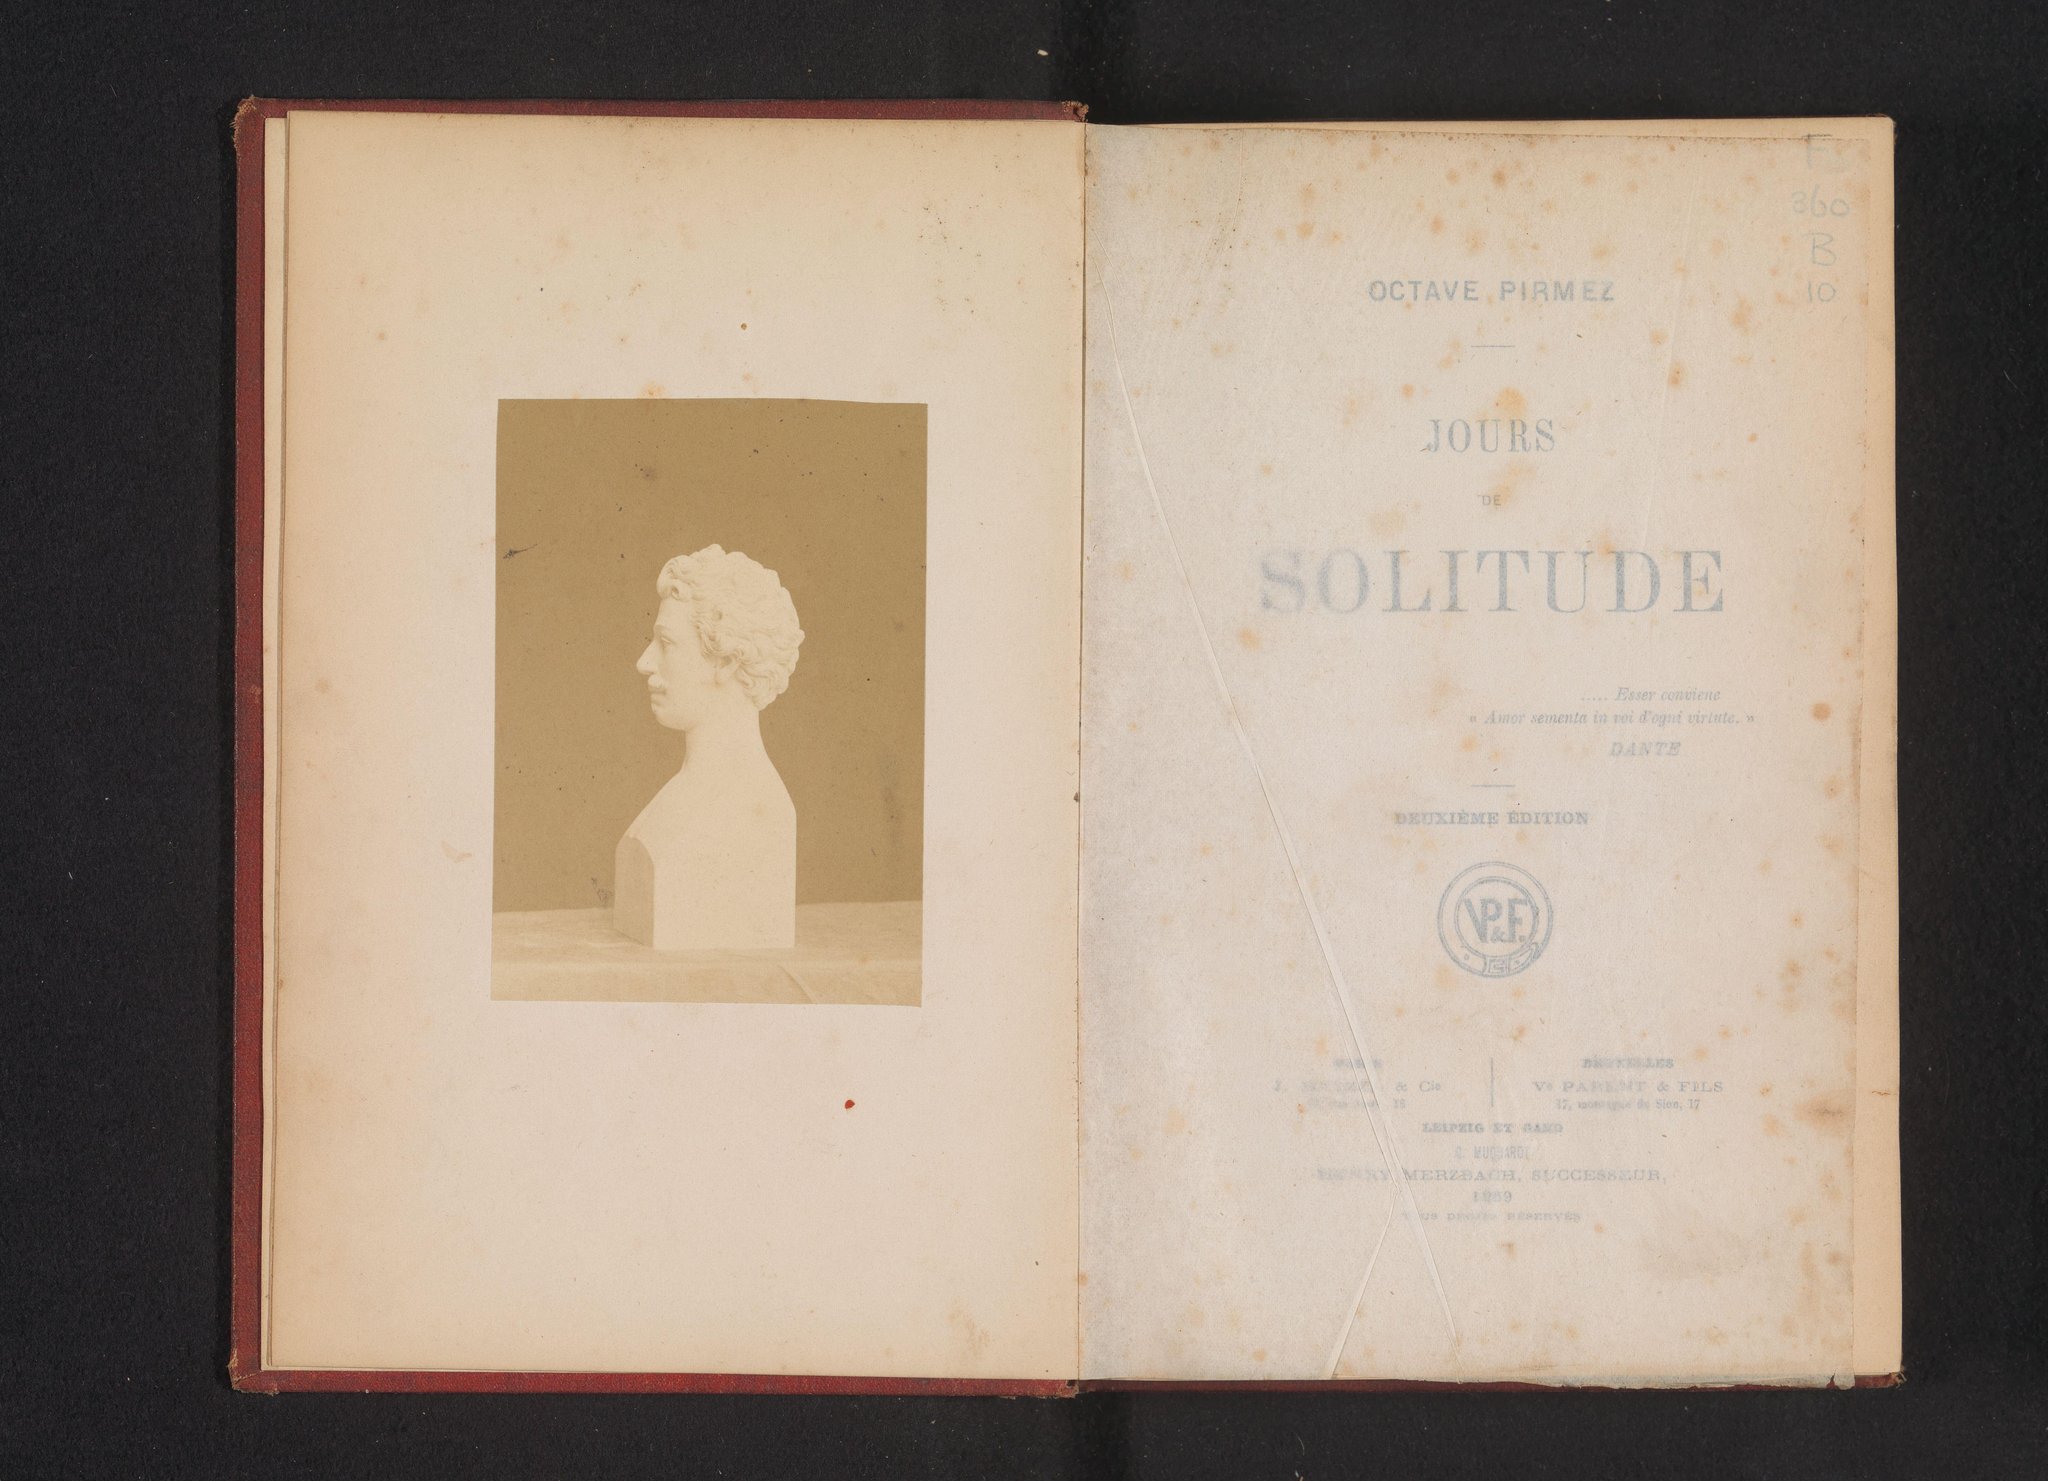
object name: page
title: Buste van Ocatve Pirmez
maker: Anonymous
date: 1864-1869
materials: photographic support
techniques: albumen print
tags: sculpture